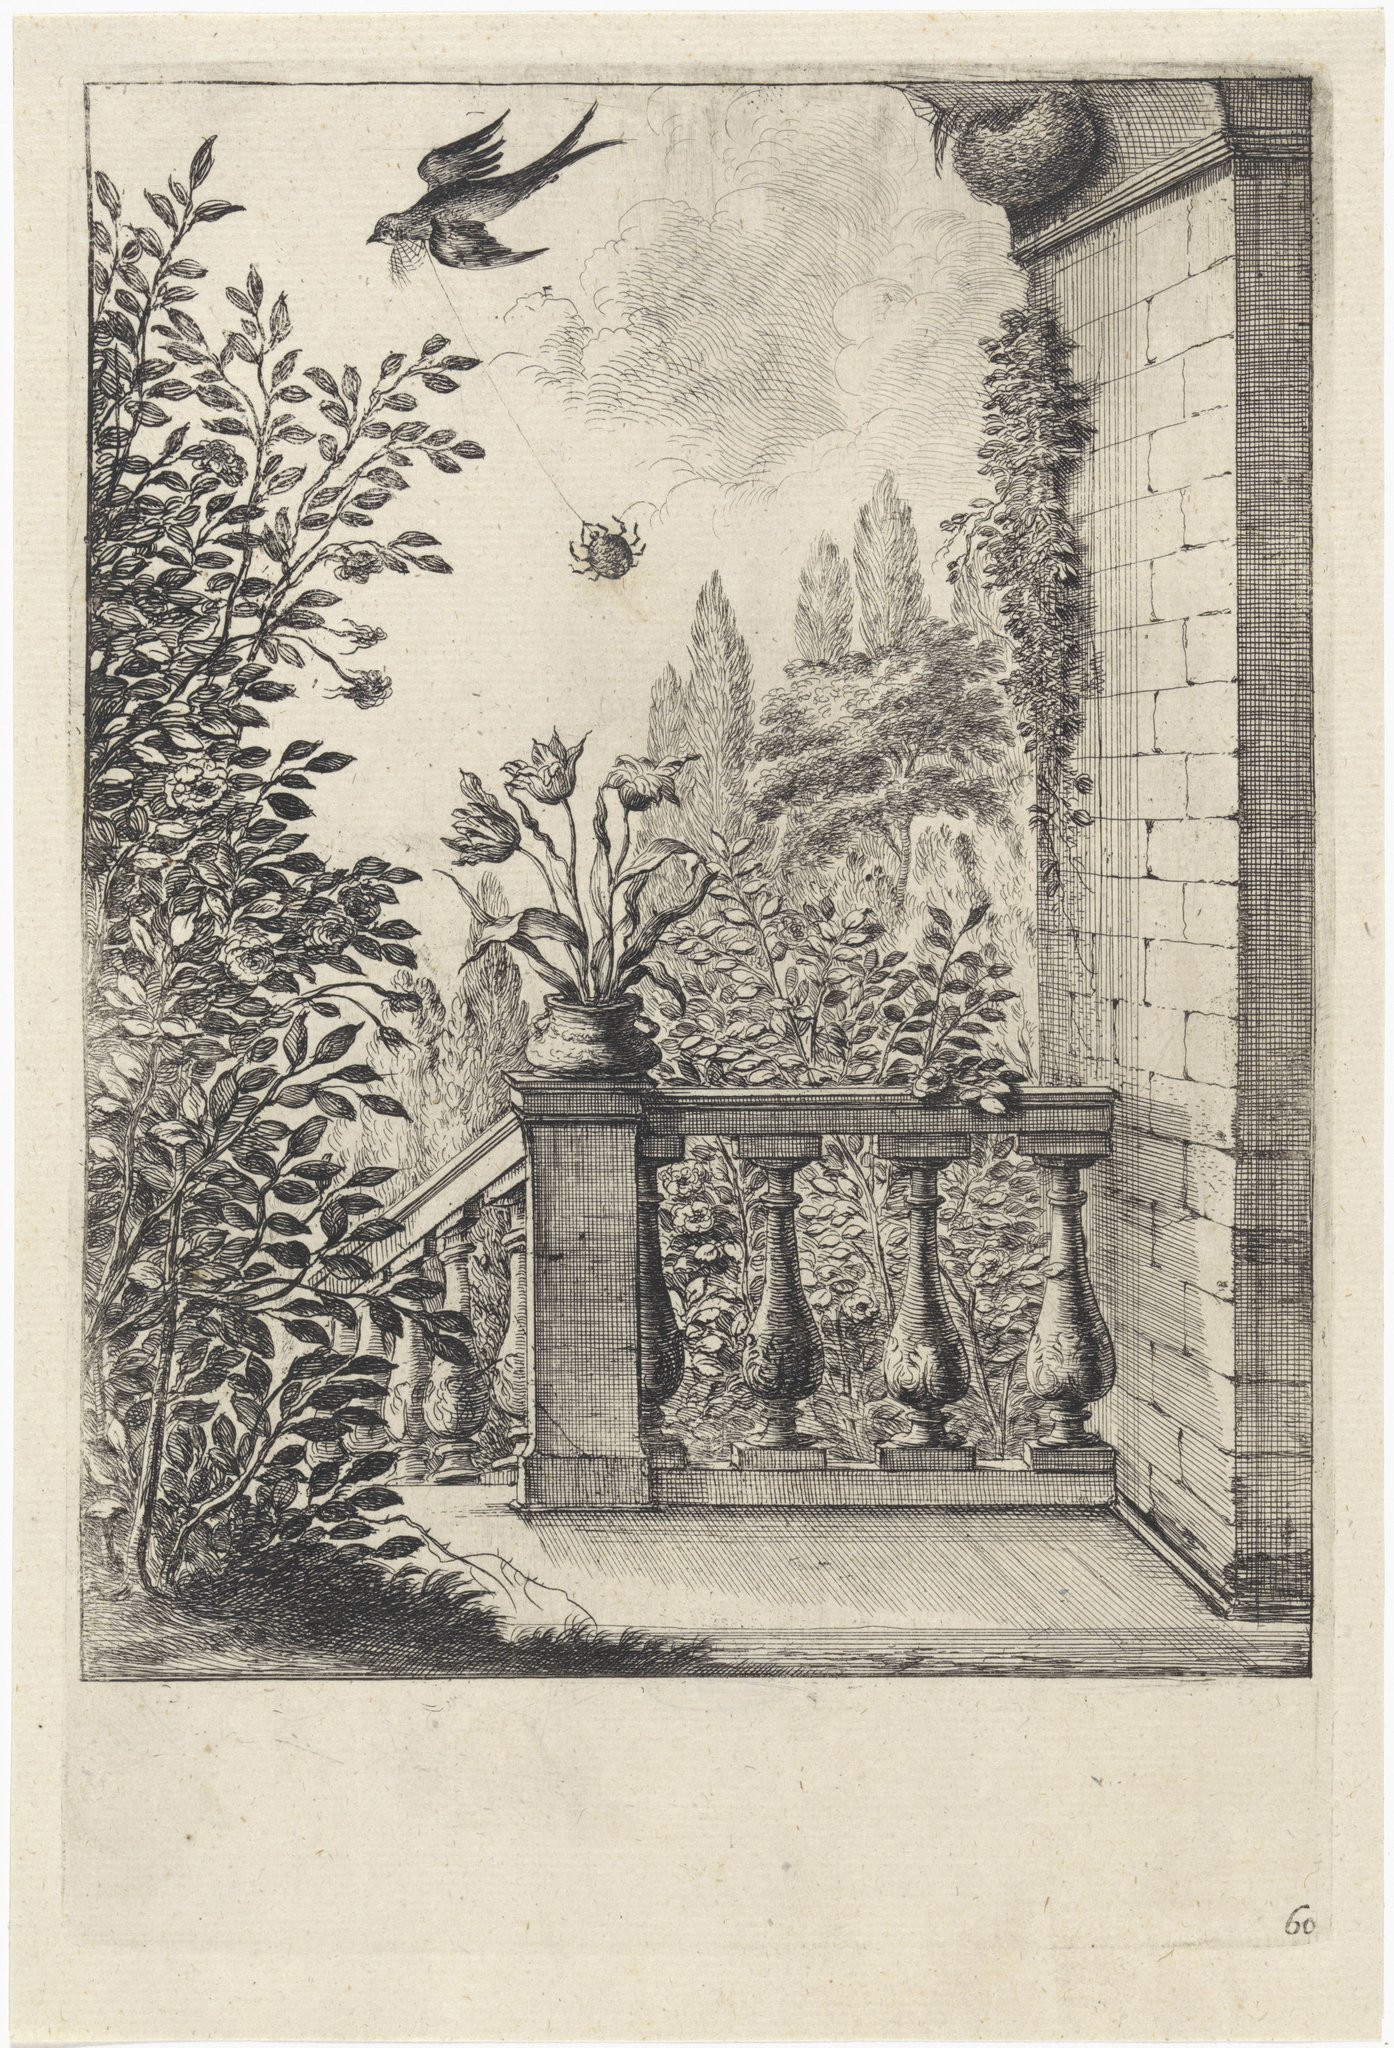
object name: book illustration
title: Fabel van de spin en de zwaluw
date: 1665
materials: paper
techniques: etching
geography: london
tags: song-birds: swallow, fables, spiders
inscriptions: collector's mark: Lugt 2228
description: Prent gebruikt in: Ogilby, John. The Fables of Aesop Paraphras'd in Verse: Adorn'd with Sculpture and Illustrated with Annotations. Londen: John Ogilby, 1665 en 1668.